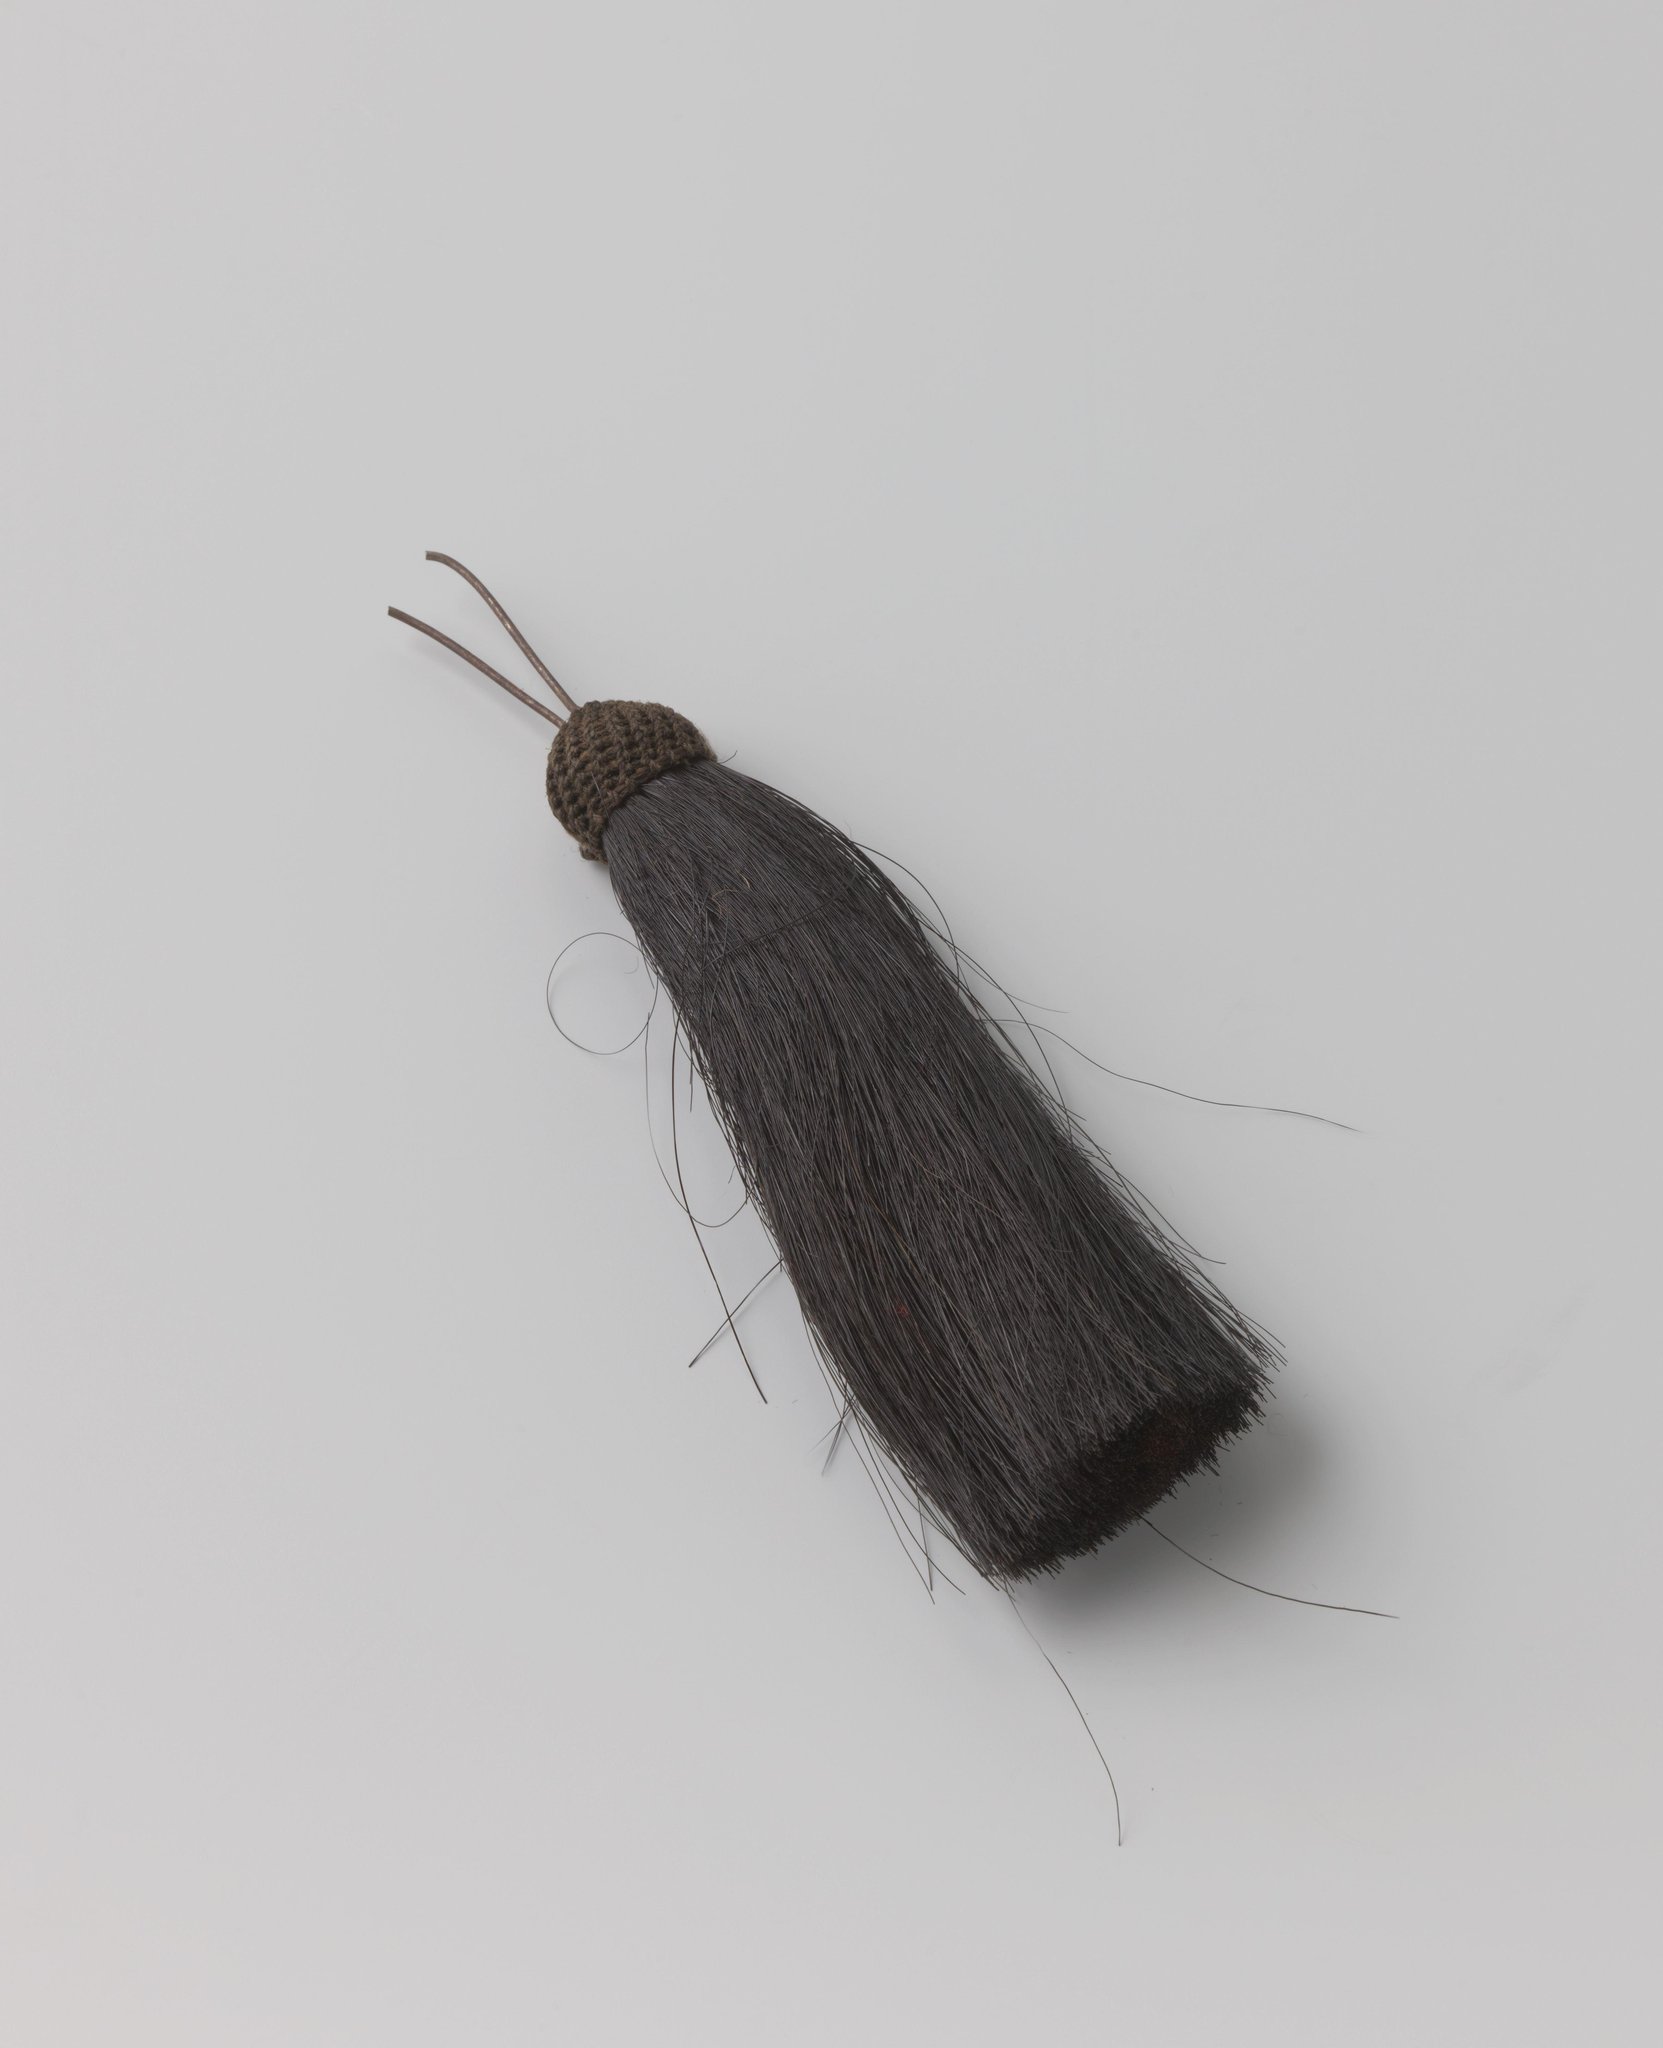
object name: plume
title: Zwarte pluim voor sjako M. 1828 voor of (1) bataljons jagers of (2) vrijwillige jagerkorpsen of (3) artillerie schutterij, voor alle rangen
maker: Anonymous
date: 1830-1839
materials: hair, metal, wool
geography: netherlands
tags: netherlands, belgium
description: Pluim van zwart paardehaar, gemonteerd op geel of wit metalen draad. Aan de kern met een netwerk van zwarte wol omgeven.